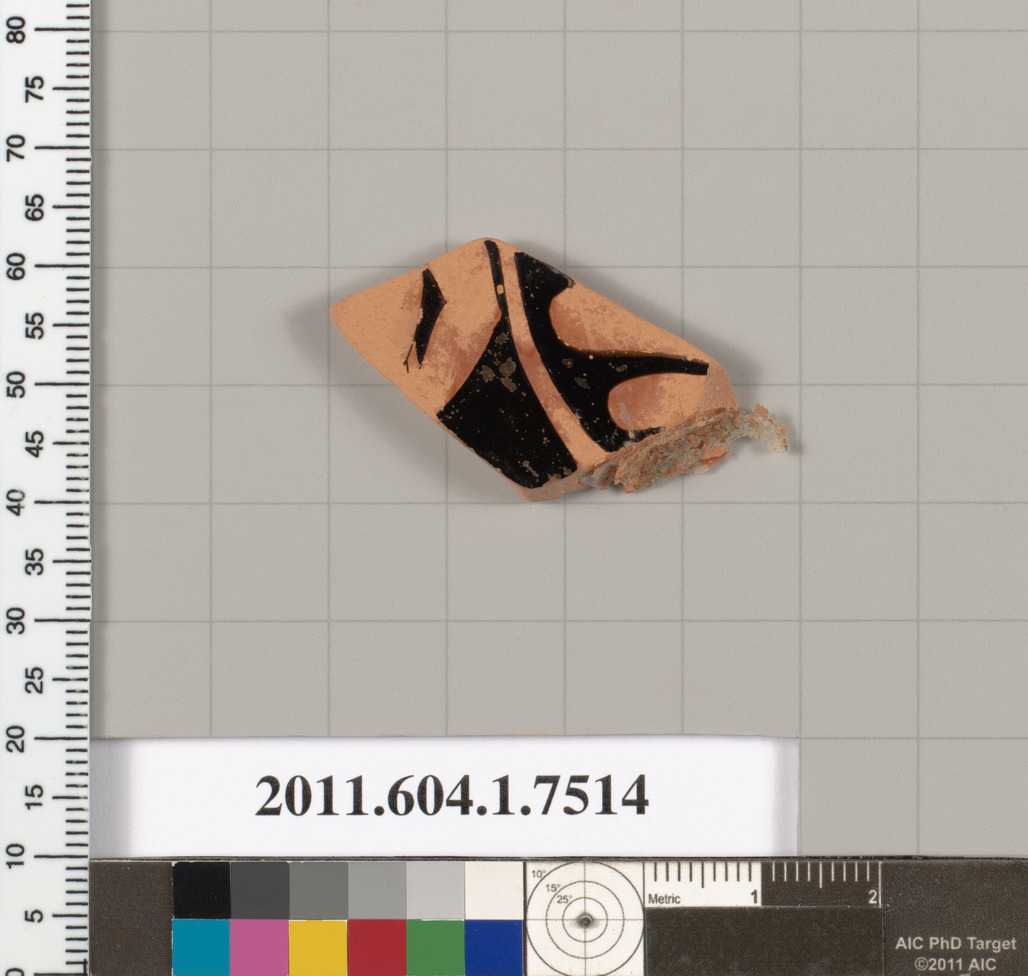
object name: kylix fragment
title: Terracotta fragment of a kylix (drinking cup)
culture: greek, attic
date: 460-450 BCE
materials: terracotta